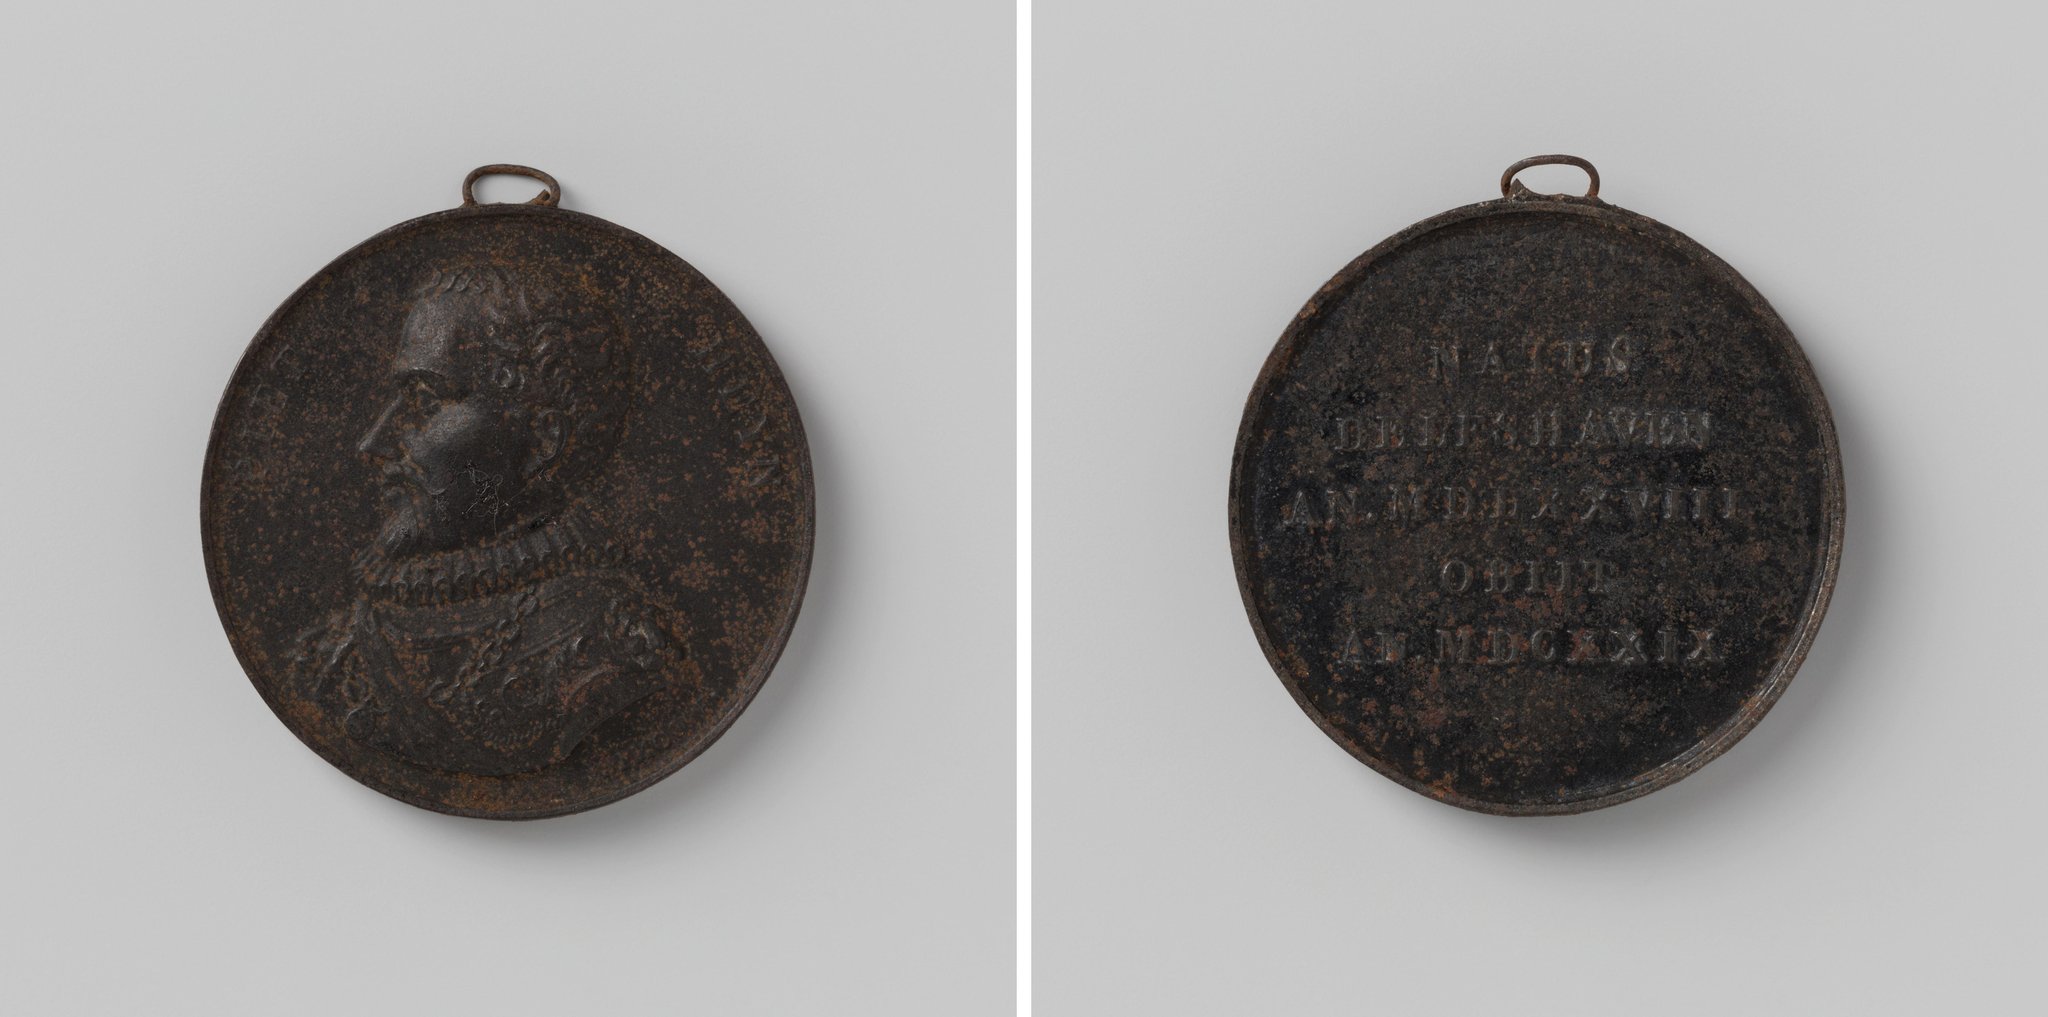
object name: history medal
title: Sneuvelen van Piet Hein voor Duinkerken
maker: jean henri simon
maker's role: medailleur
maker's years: 1752-1834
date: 1816-1834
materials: iron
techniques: striking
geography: brussels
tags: duinkerke, luitenant-admiraal, piet hein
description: IJzeren penning met draagoog. Voorzijde: borststuk man binnen omschrift. Keerzijde: opschrift